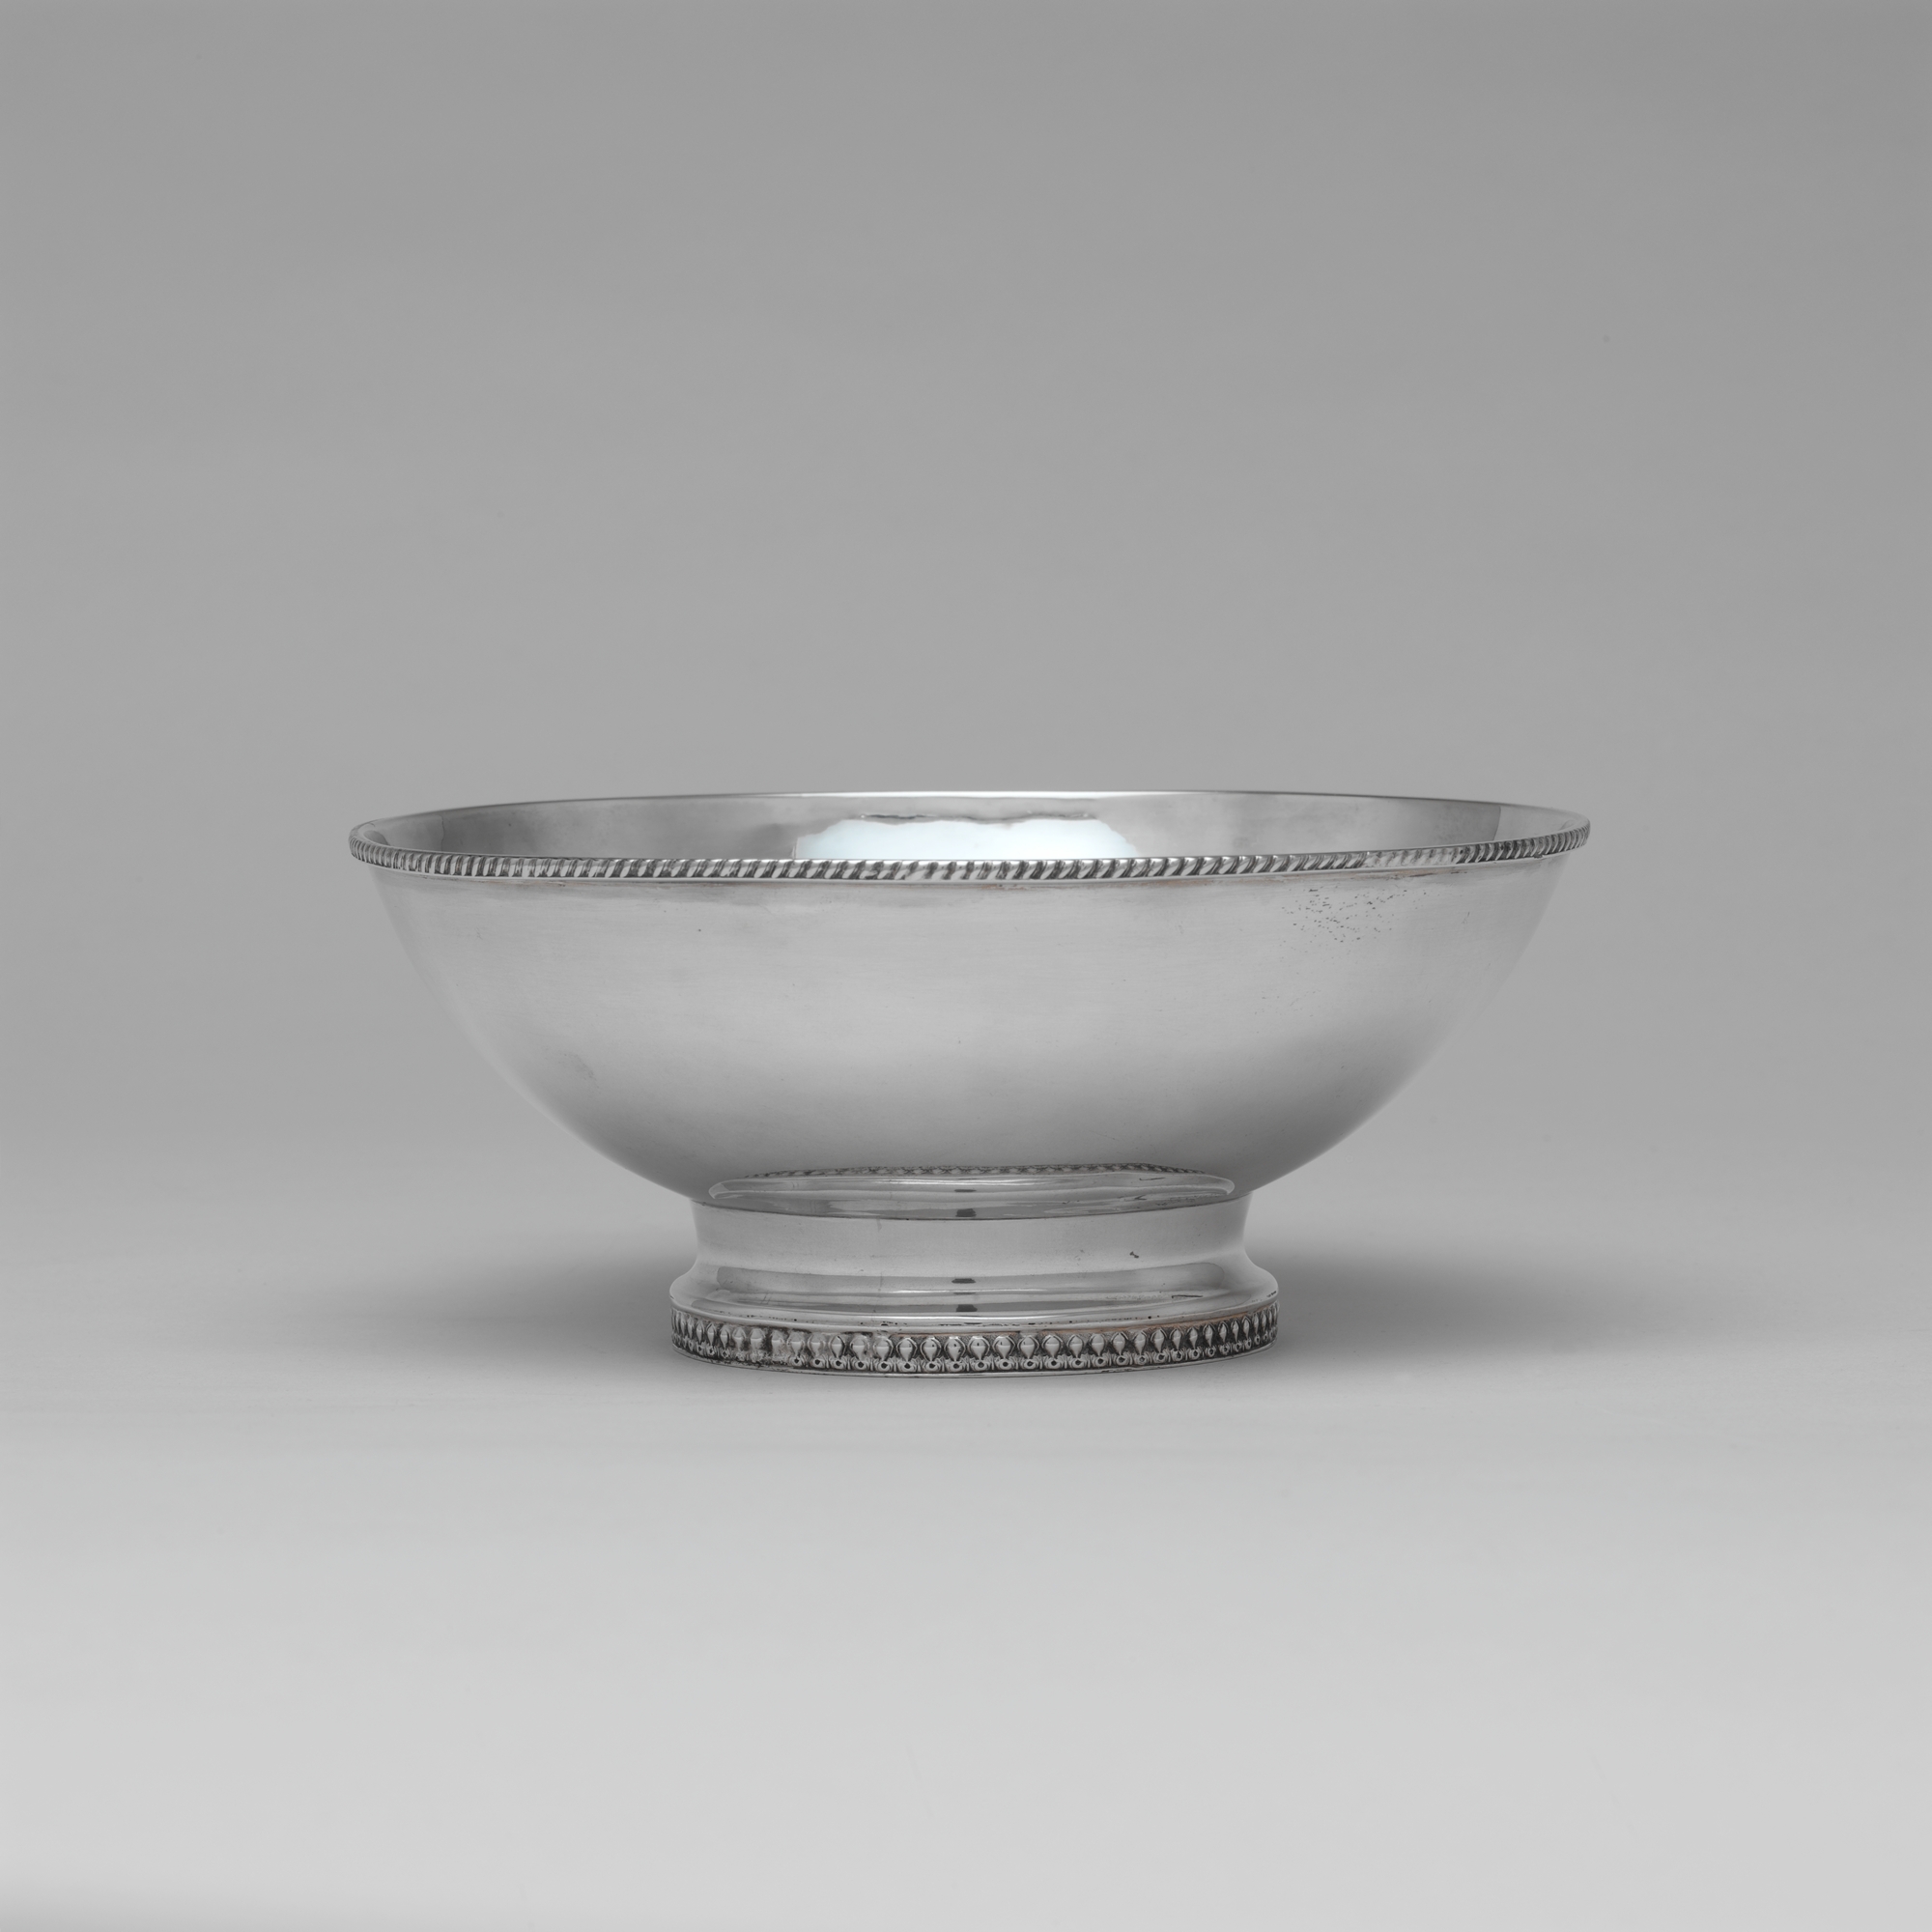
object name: bowl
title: Punch Bowl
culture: american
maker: chauncey johnson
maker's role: maker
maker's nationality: american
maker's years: 1822-1841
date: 1825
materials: silver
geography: united states